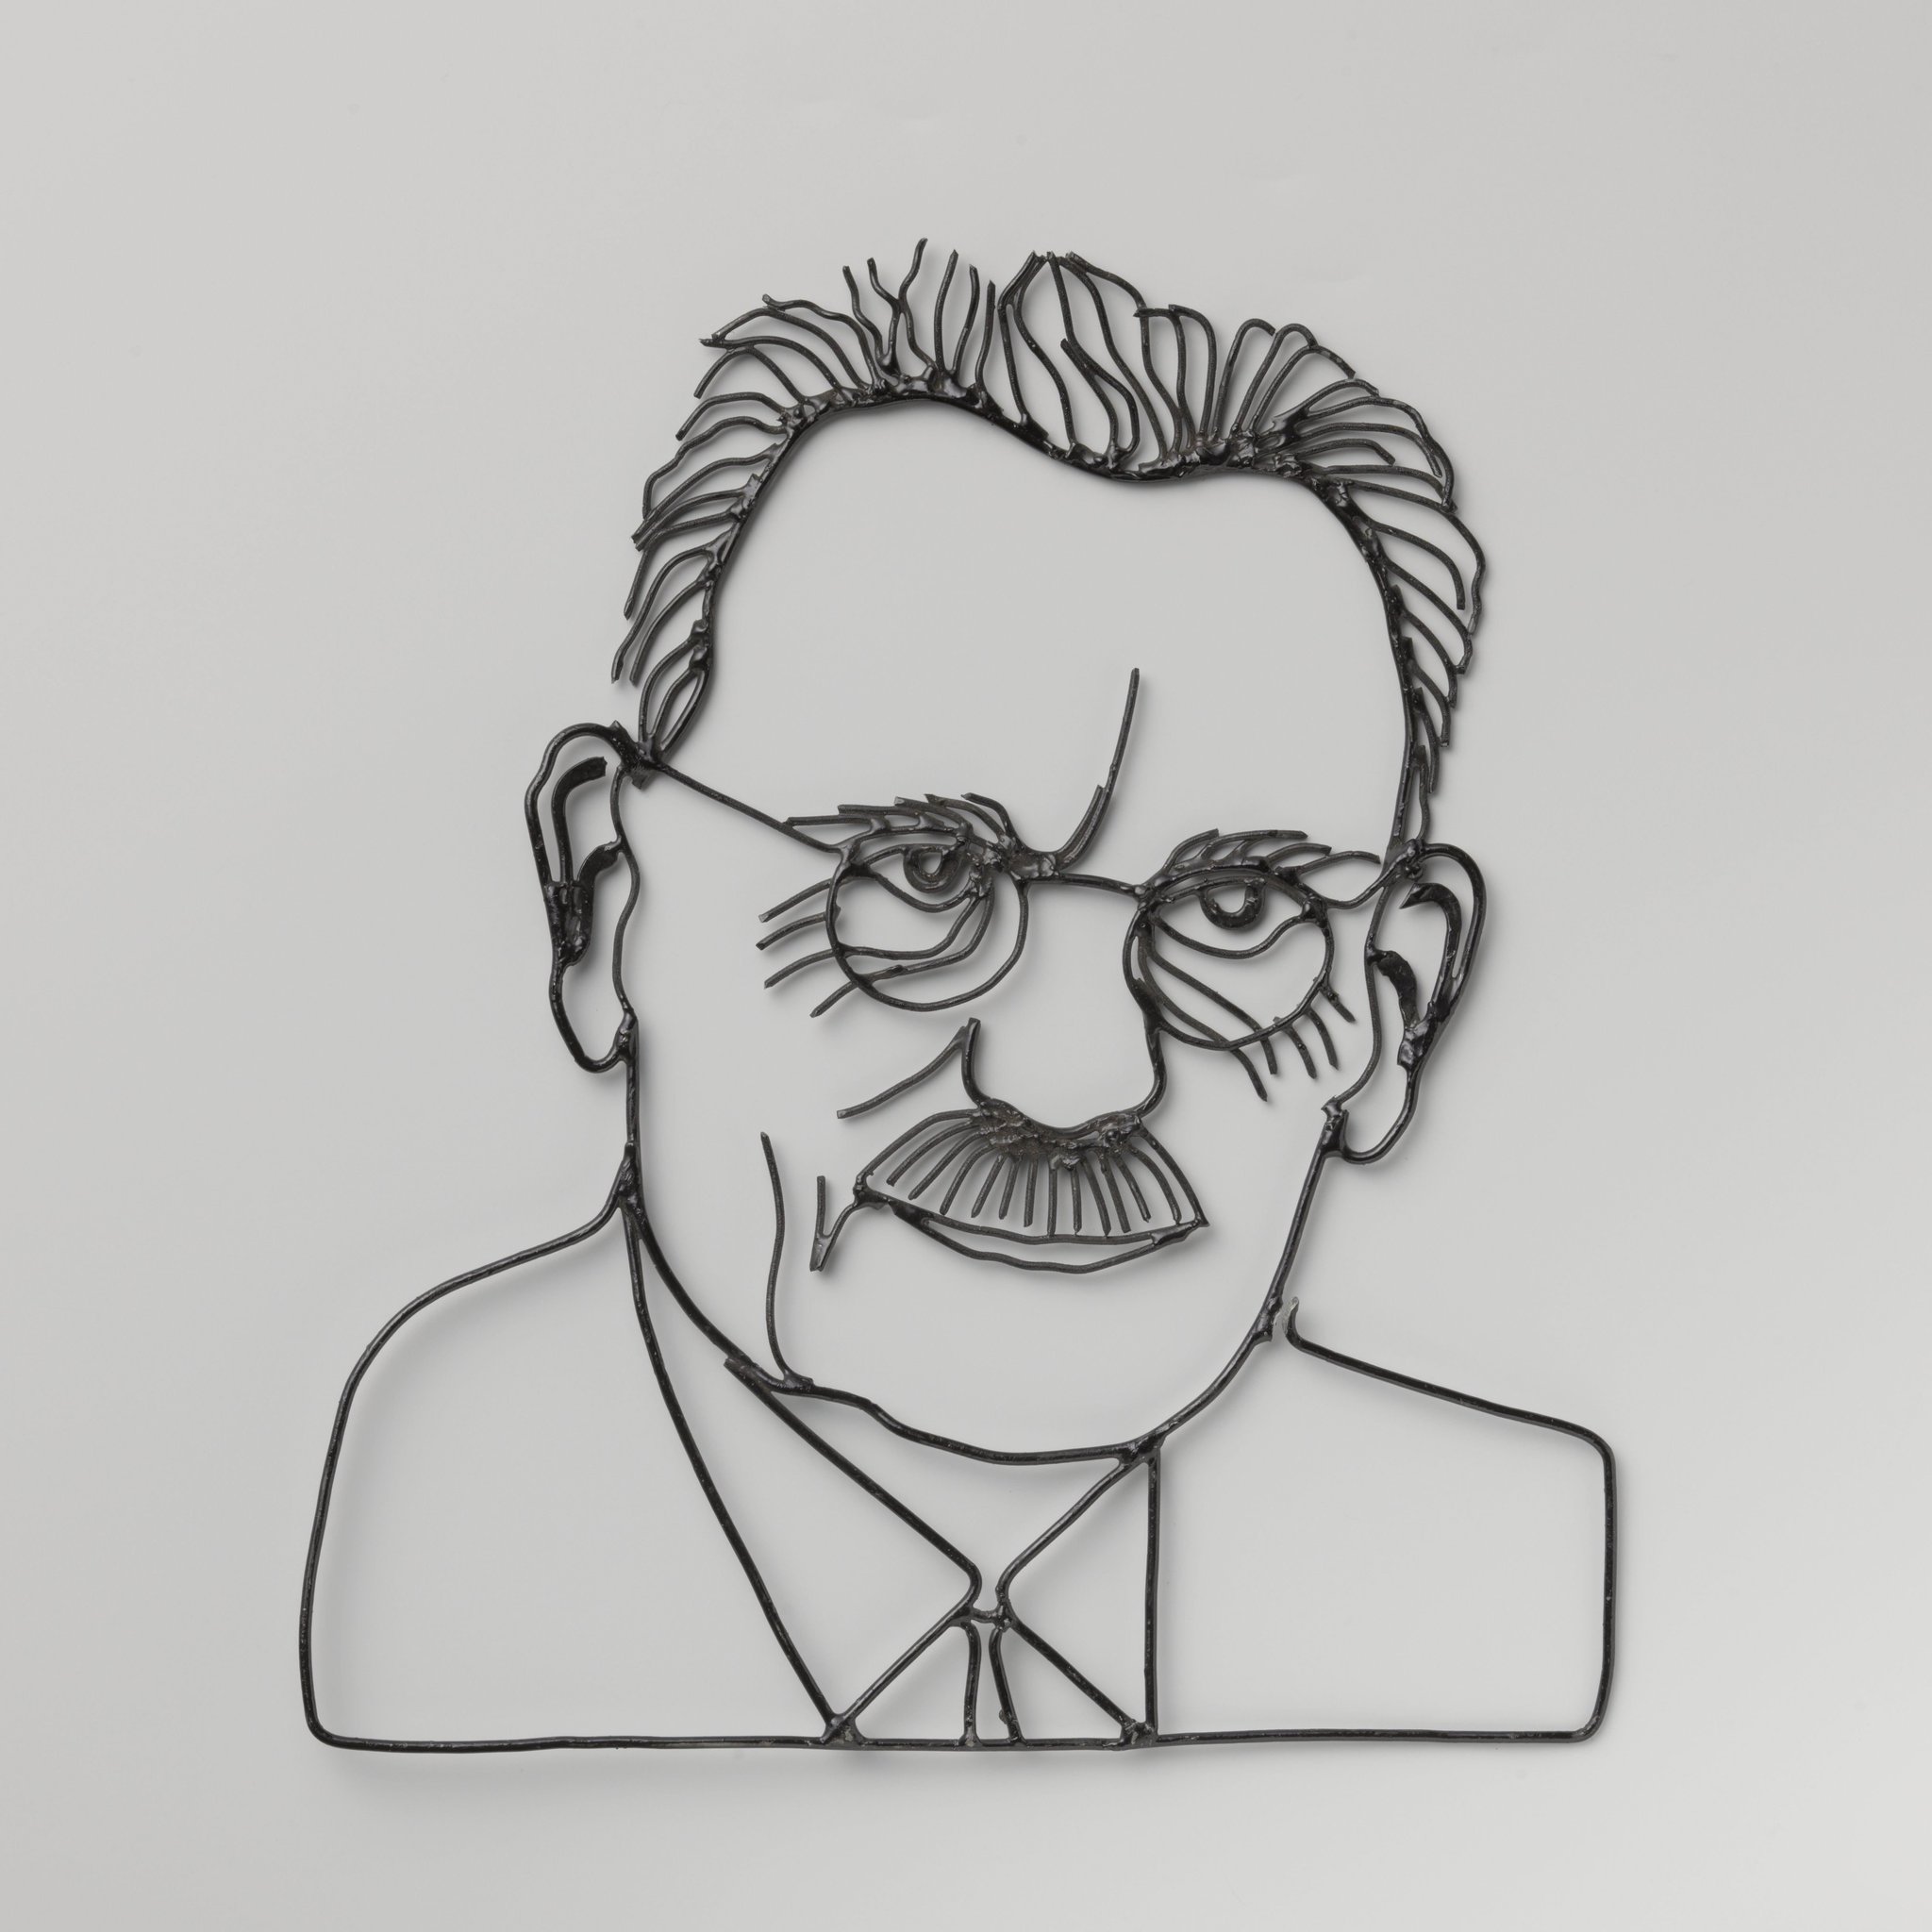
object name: relief sculpture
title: Portret van Willem Drees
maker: Anonymous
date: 1950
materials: cardboard, cork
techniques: metalworking, painting, soldering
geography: netherlands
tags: amsterdam, willem drees, netherlands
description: Portret gevormd van zwart geverfd ijzerdraad, op een stuk blank karton geklemd tussen twee kurken.